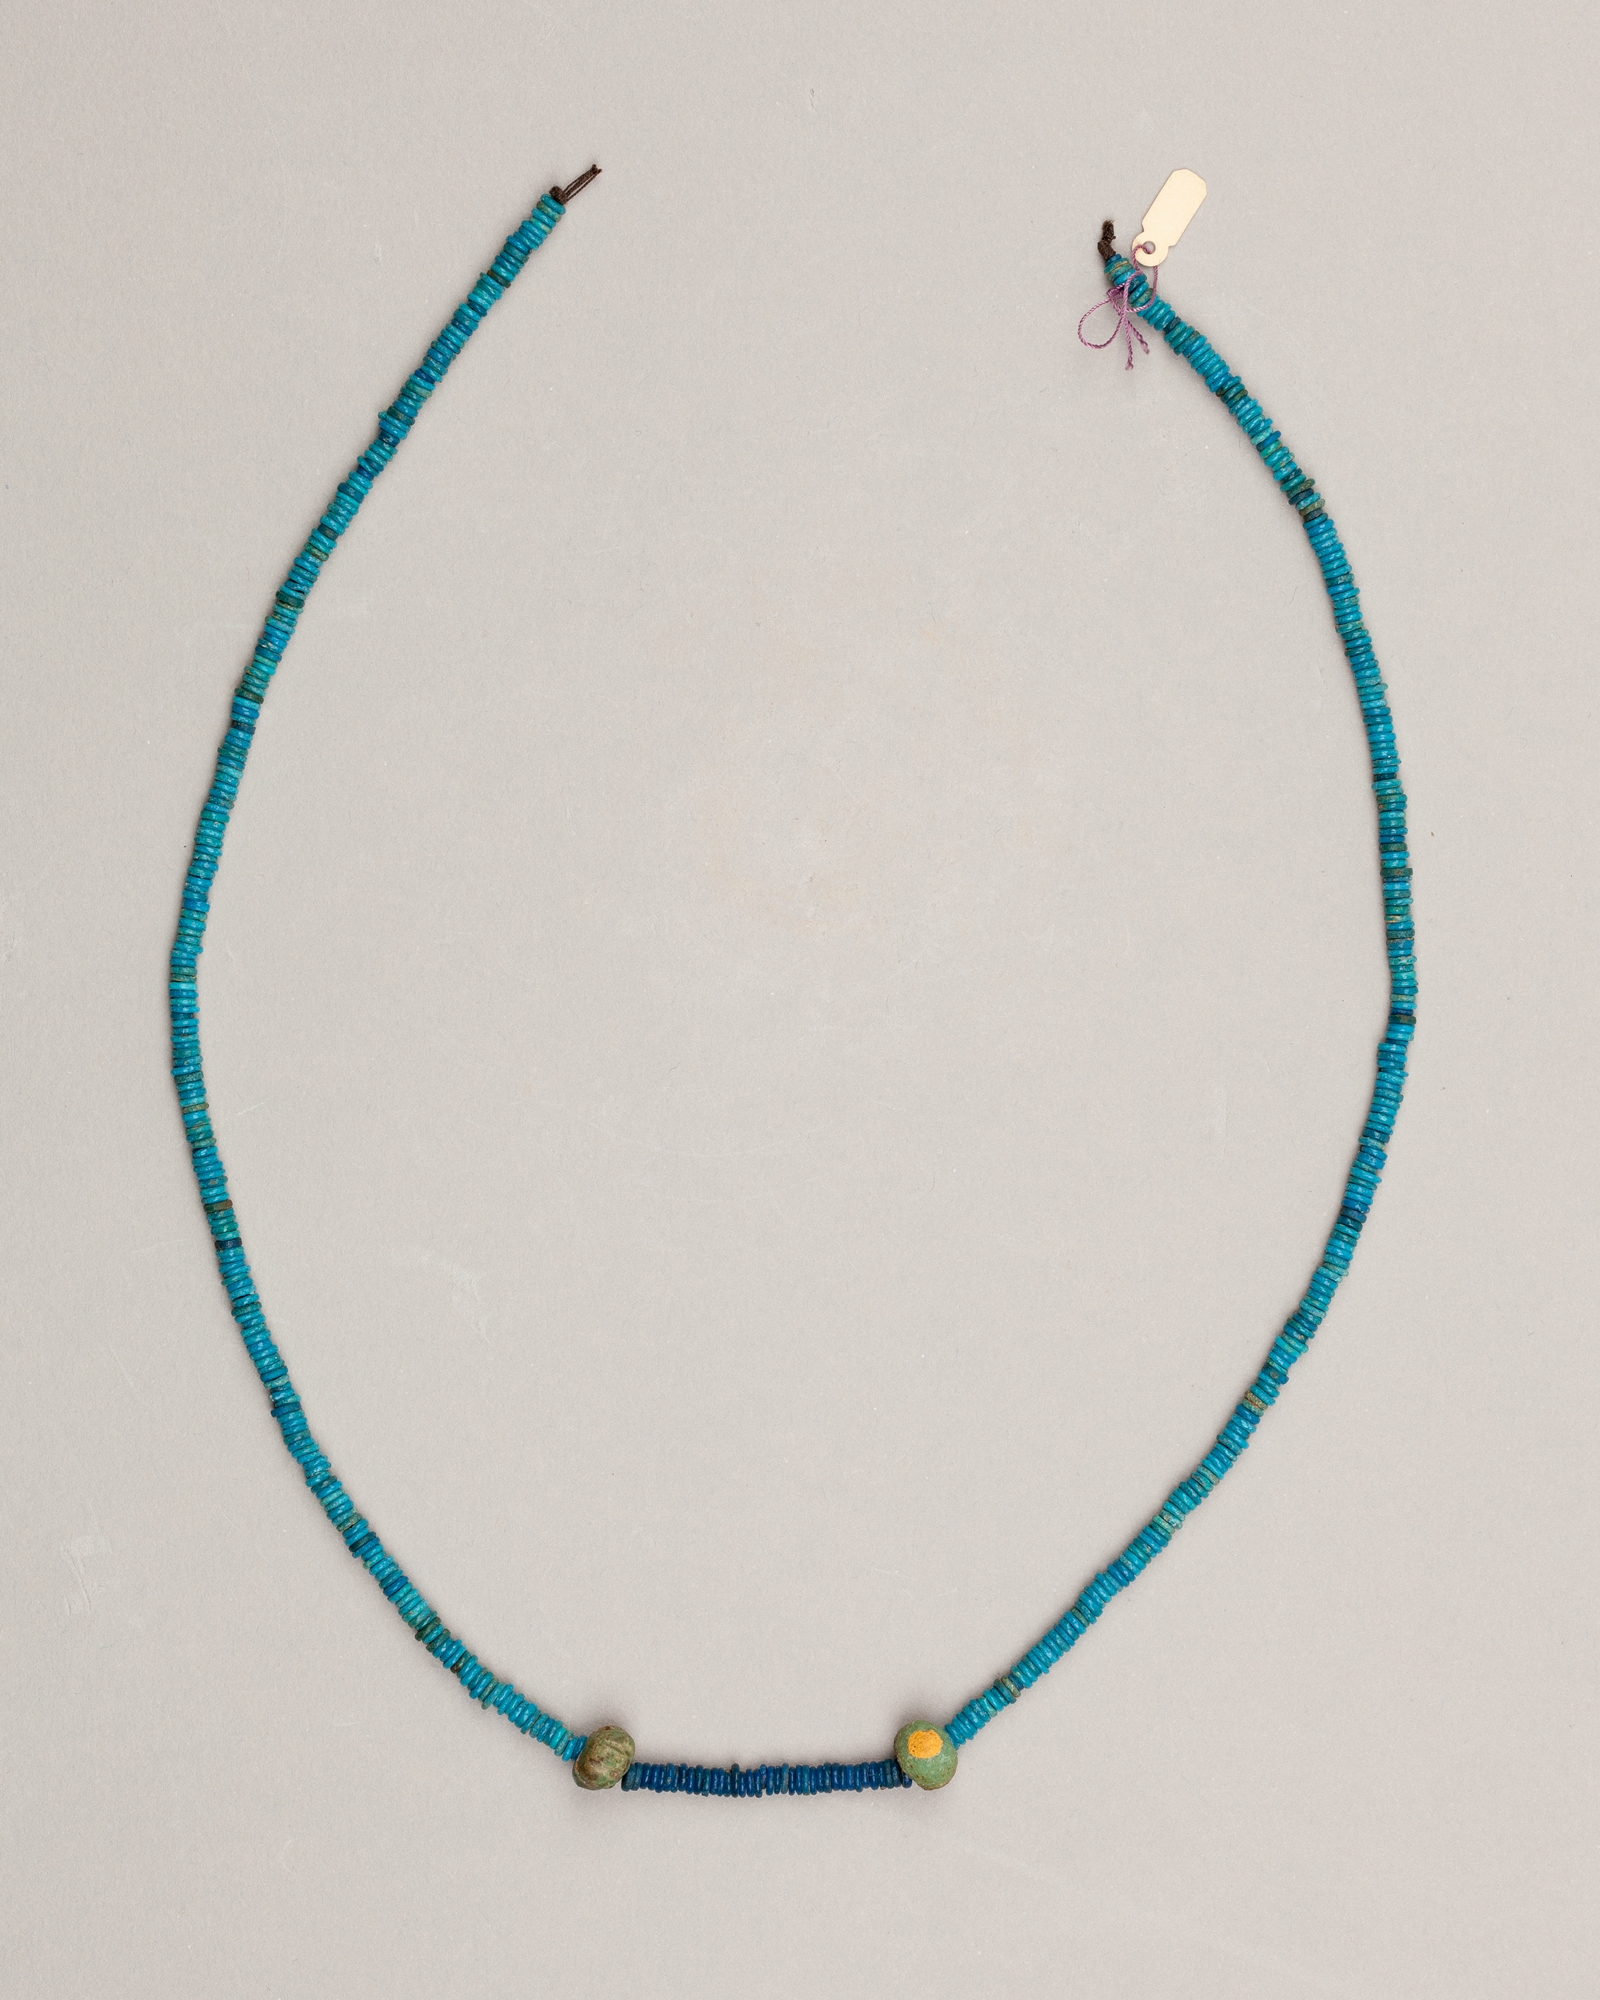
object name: bead, string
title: String of ring beads with two ball beads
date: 2030-1640 BCE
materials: faience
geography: egypt